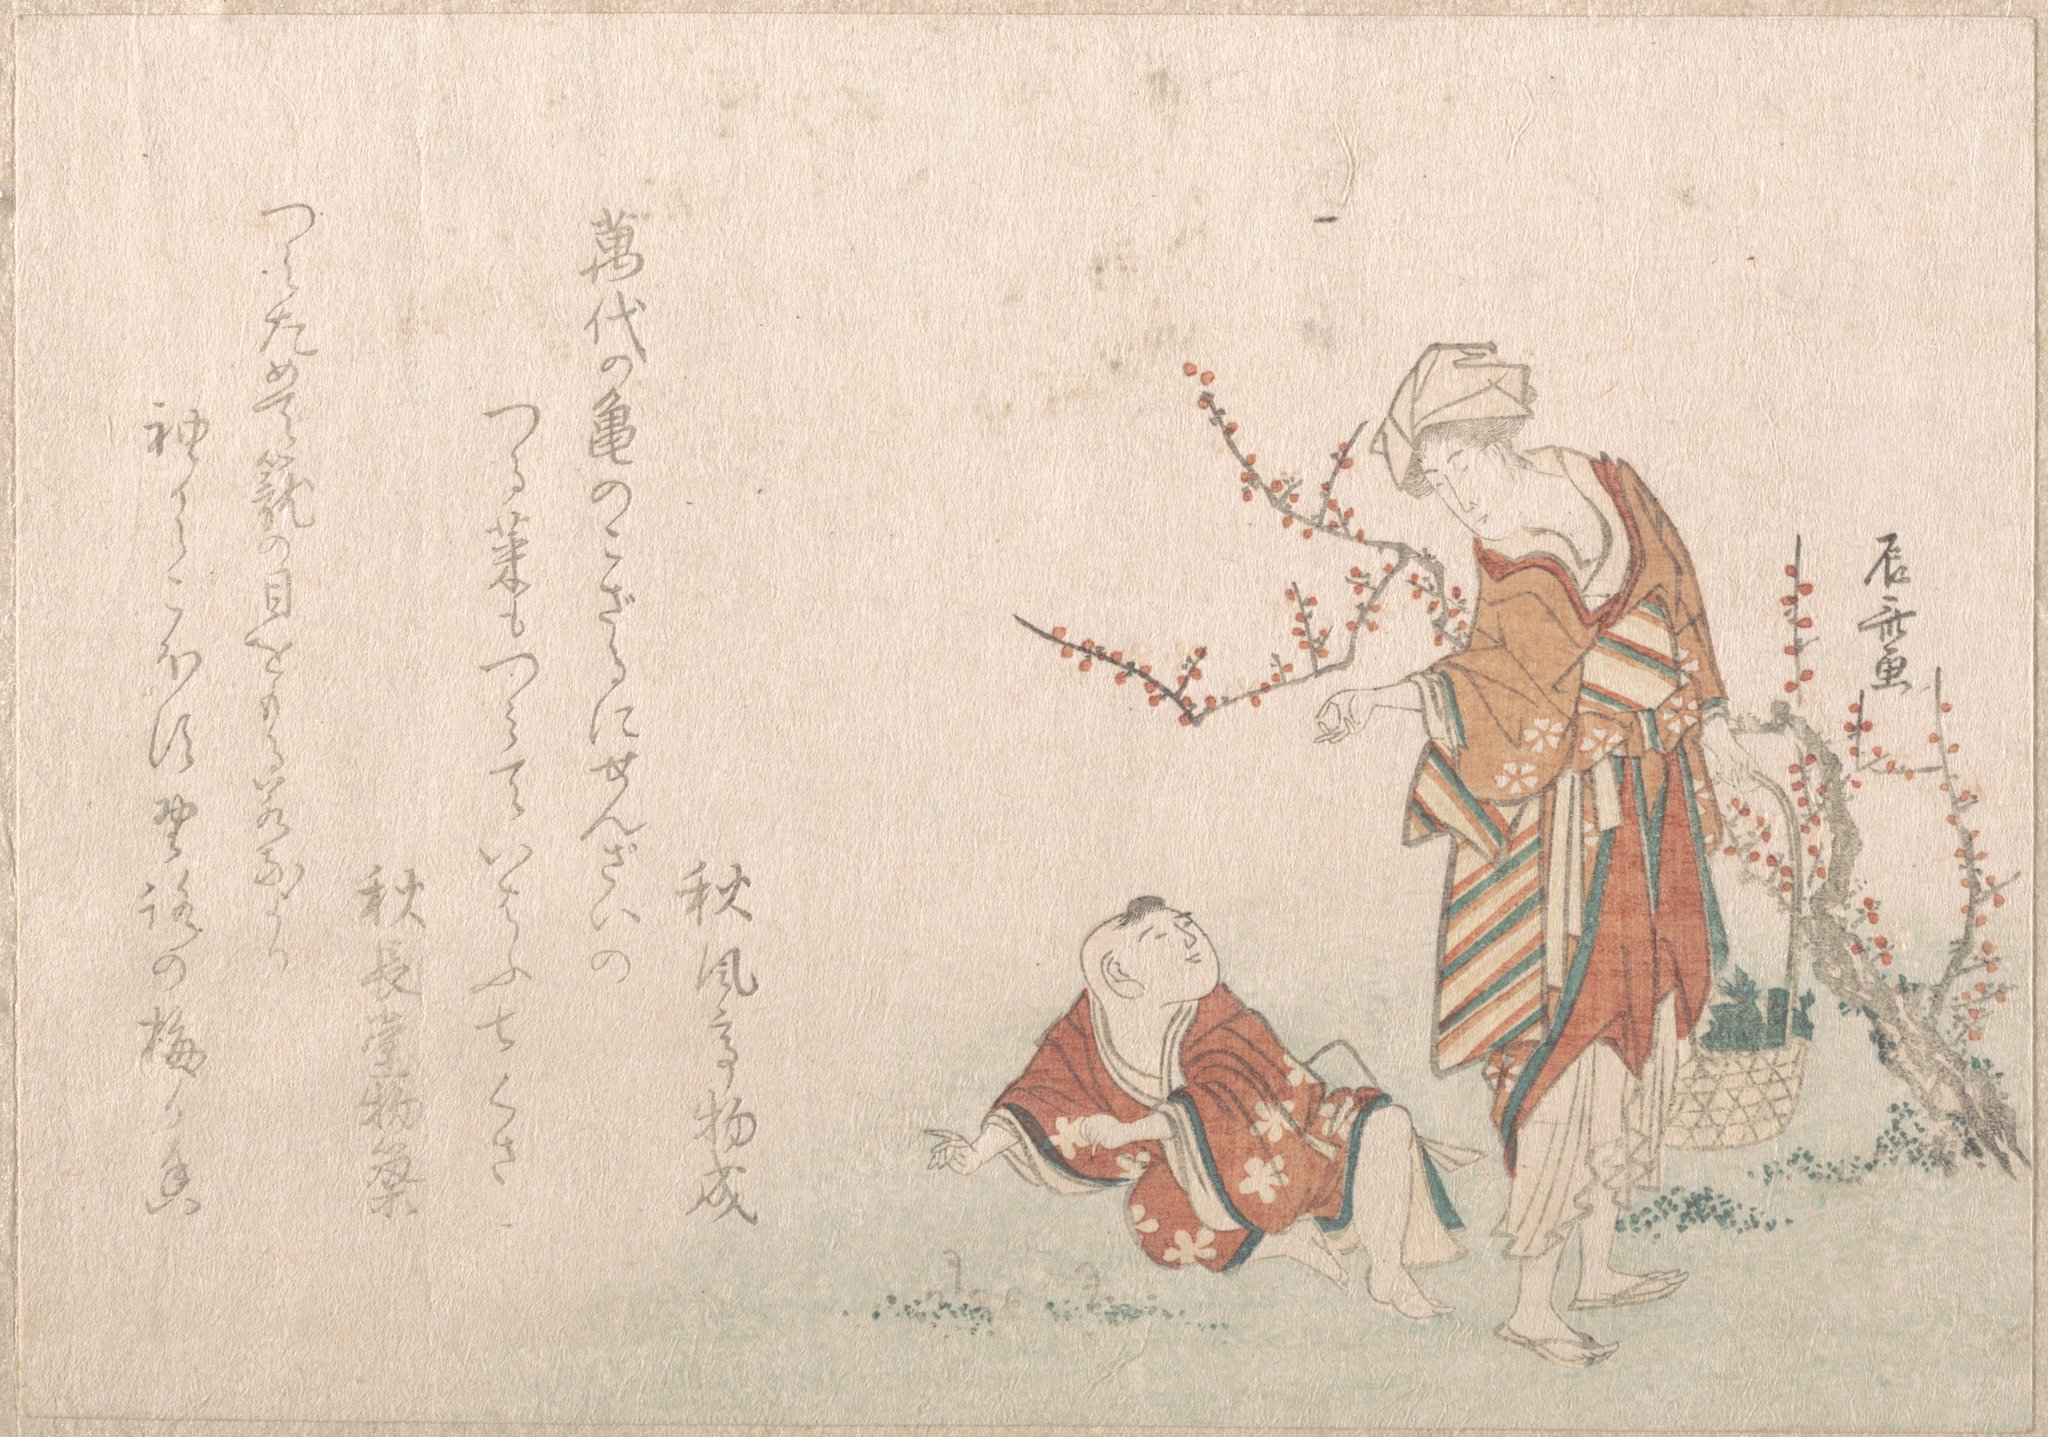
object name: print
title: Woman and Boy Gathering Herbs by a Plum Tree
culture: japanese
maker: ryūryūkyo shinsai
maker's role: artist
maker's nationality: japanese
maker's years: 1799-1823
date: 1801-1900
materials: ink, paper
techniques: surimono, woodblock print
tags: boys,women,trees